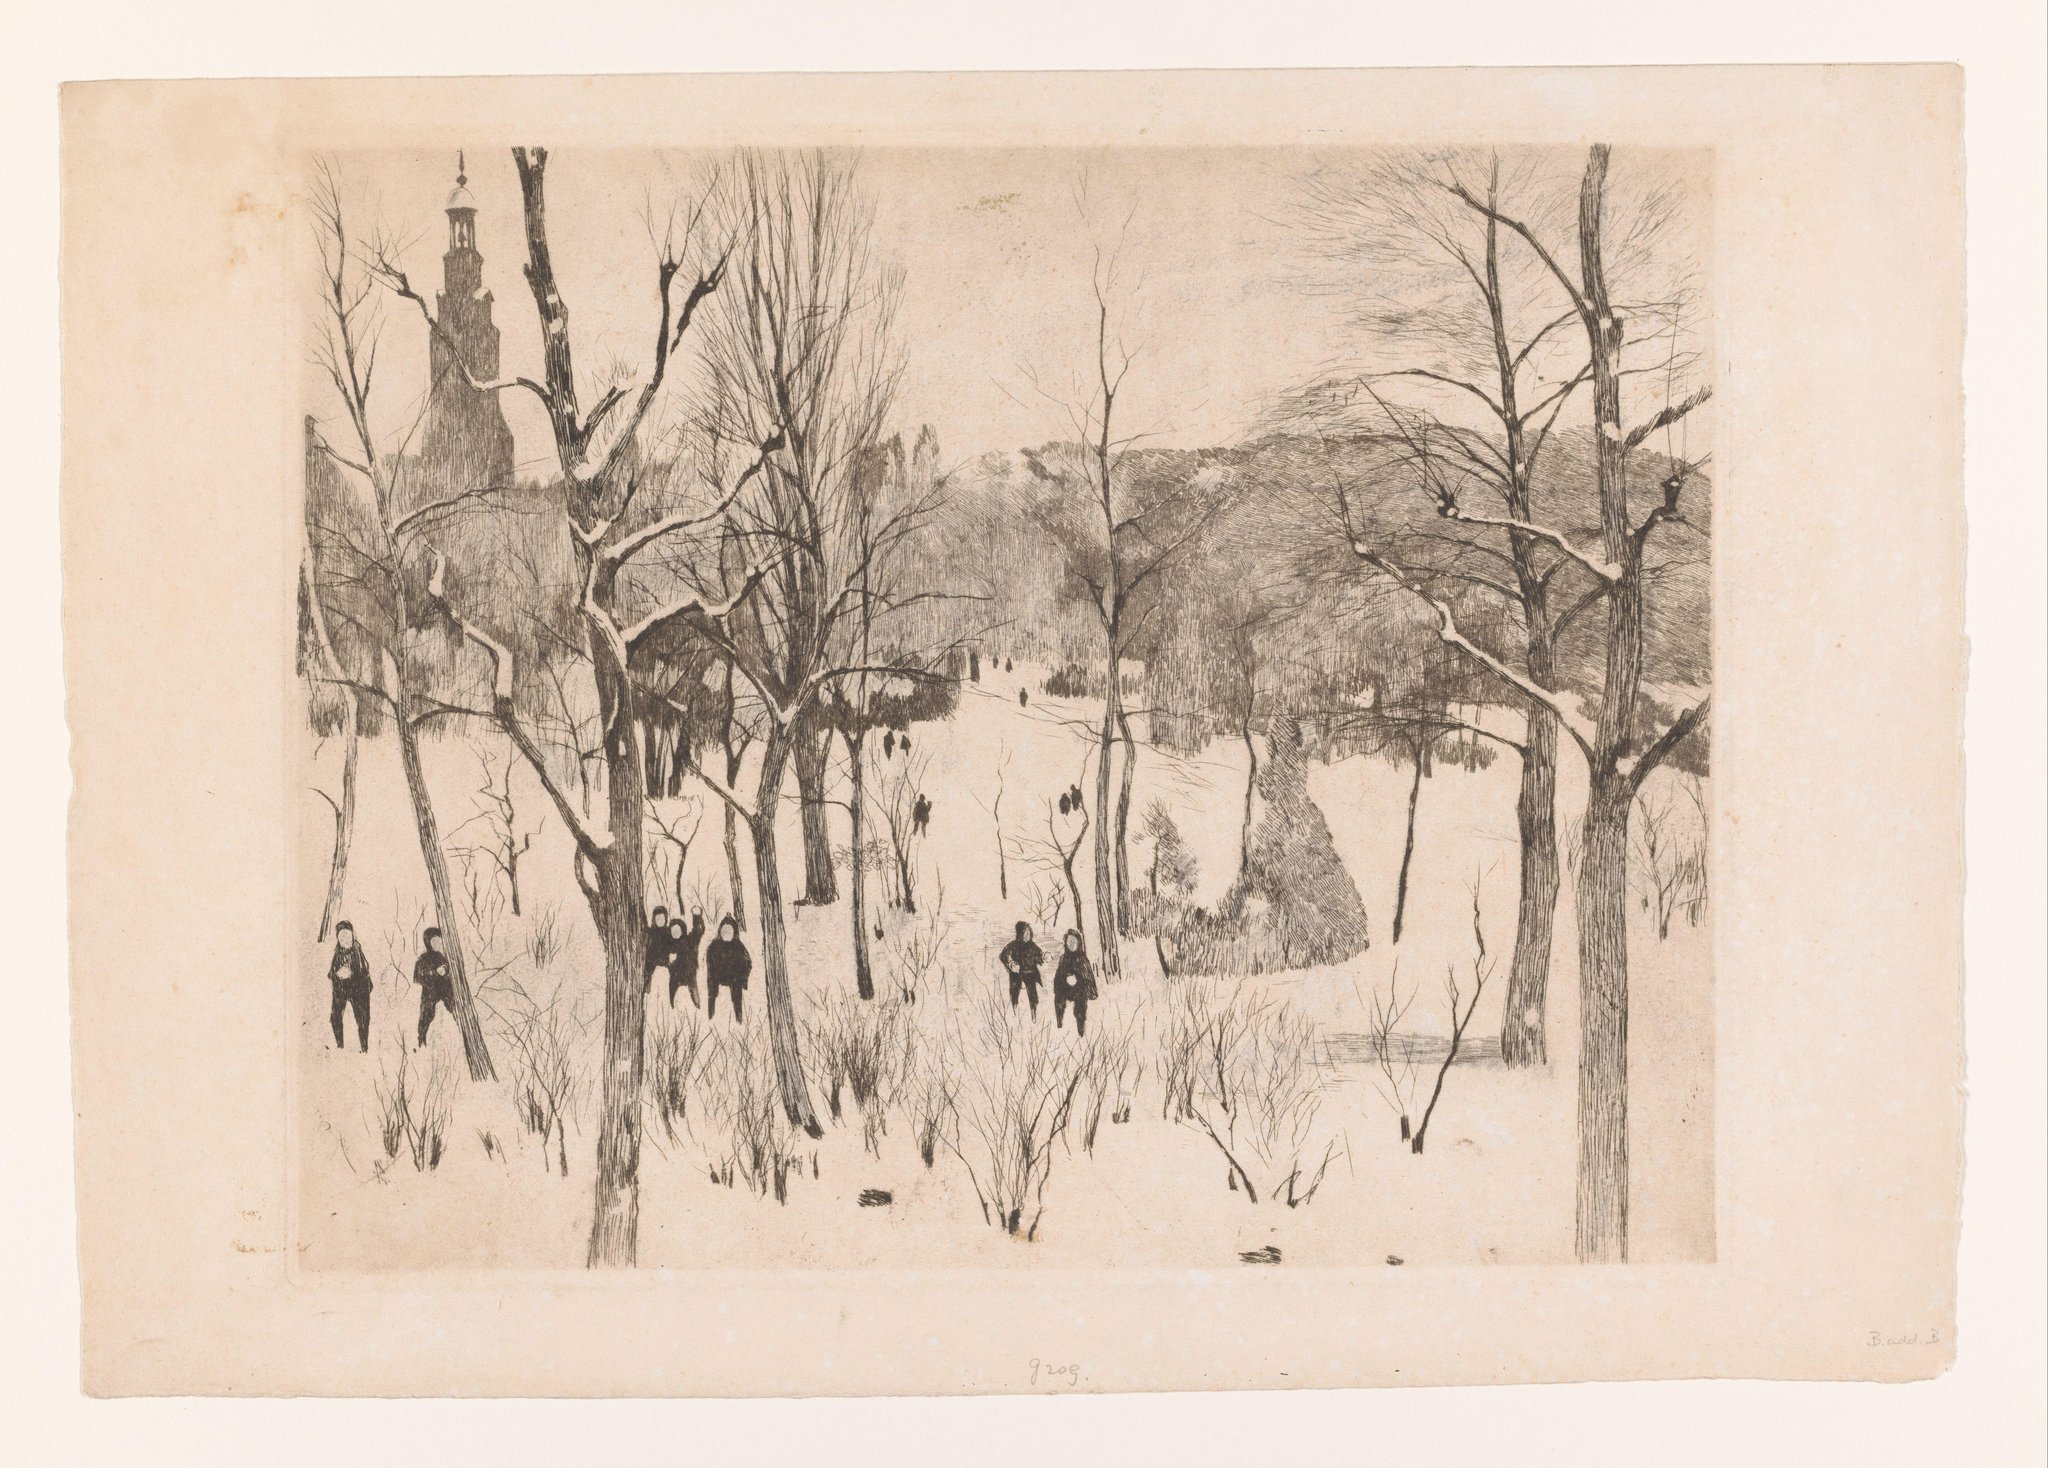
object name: print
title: Oosterpark met spelende kinderen in de sneeuw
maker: willem witsen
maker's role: draughtsman, painter, print maker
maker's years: 1860-1923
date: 1922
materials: chalk, paper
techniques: etching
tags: playing with snow and ice, parts of church exterior and annexes: tower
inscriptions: annotation: ‘15a/ 11-'76 [in getekende driehoek]’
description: Op de achtergrond de toren van de Muiderkerk. Uitzicht vanuit het woonhuis van Witsen.